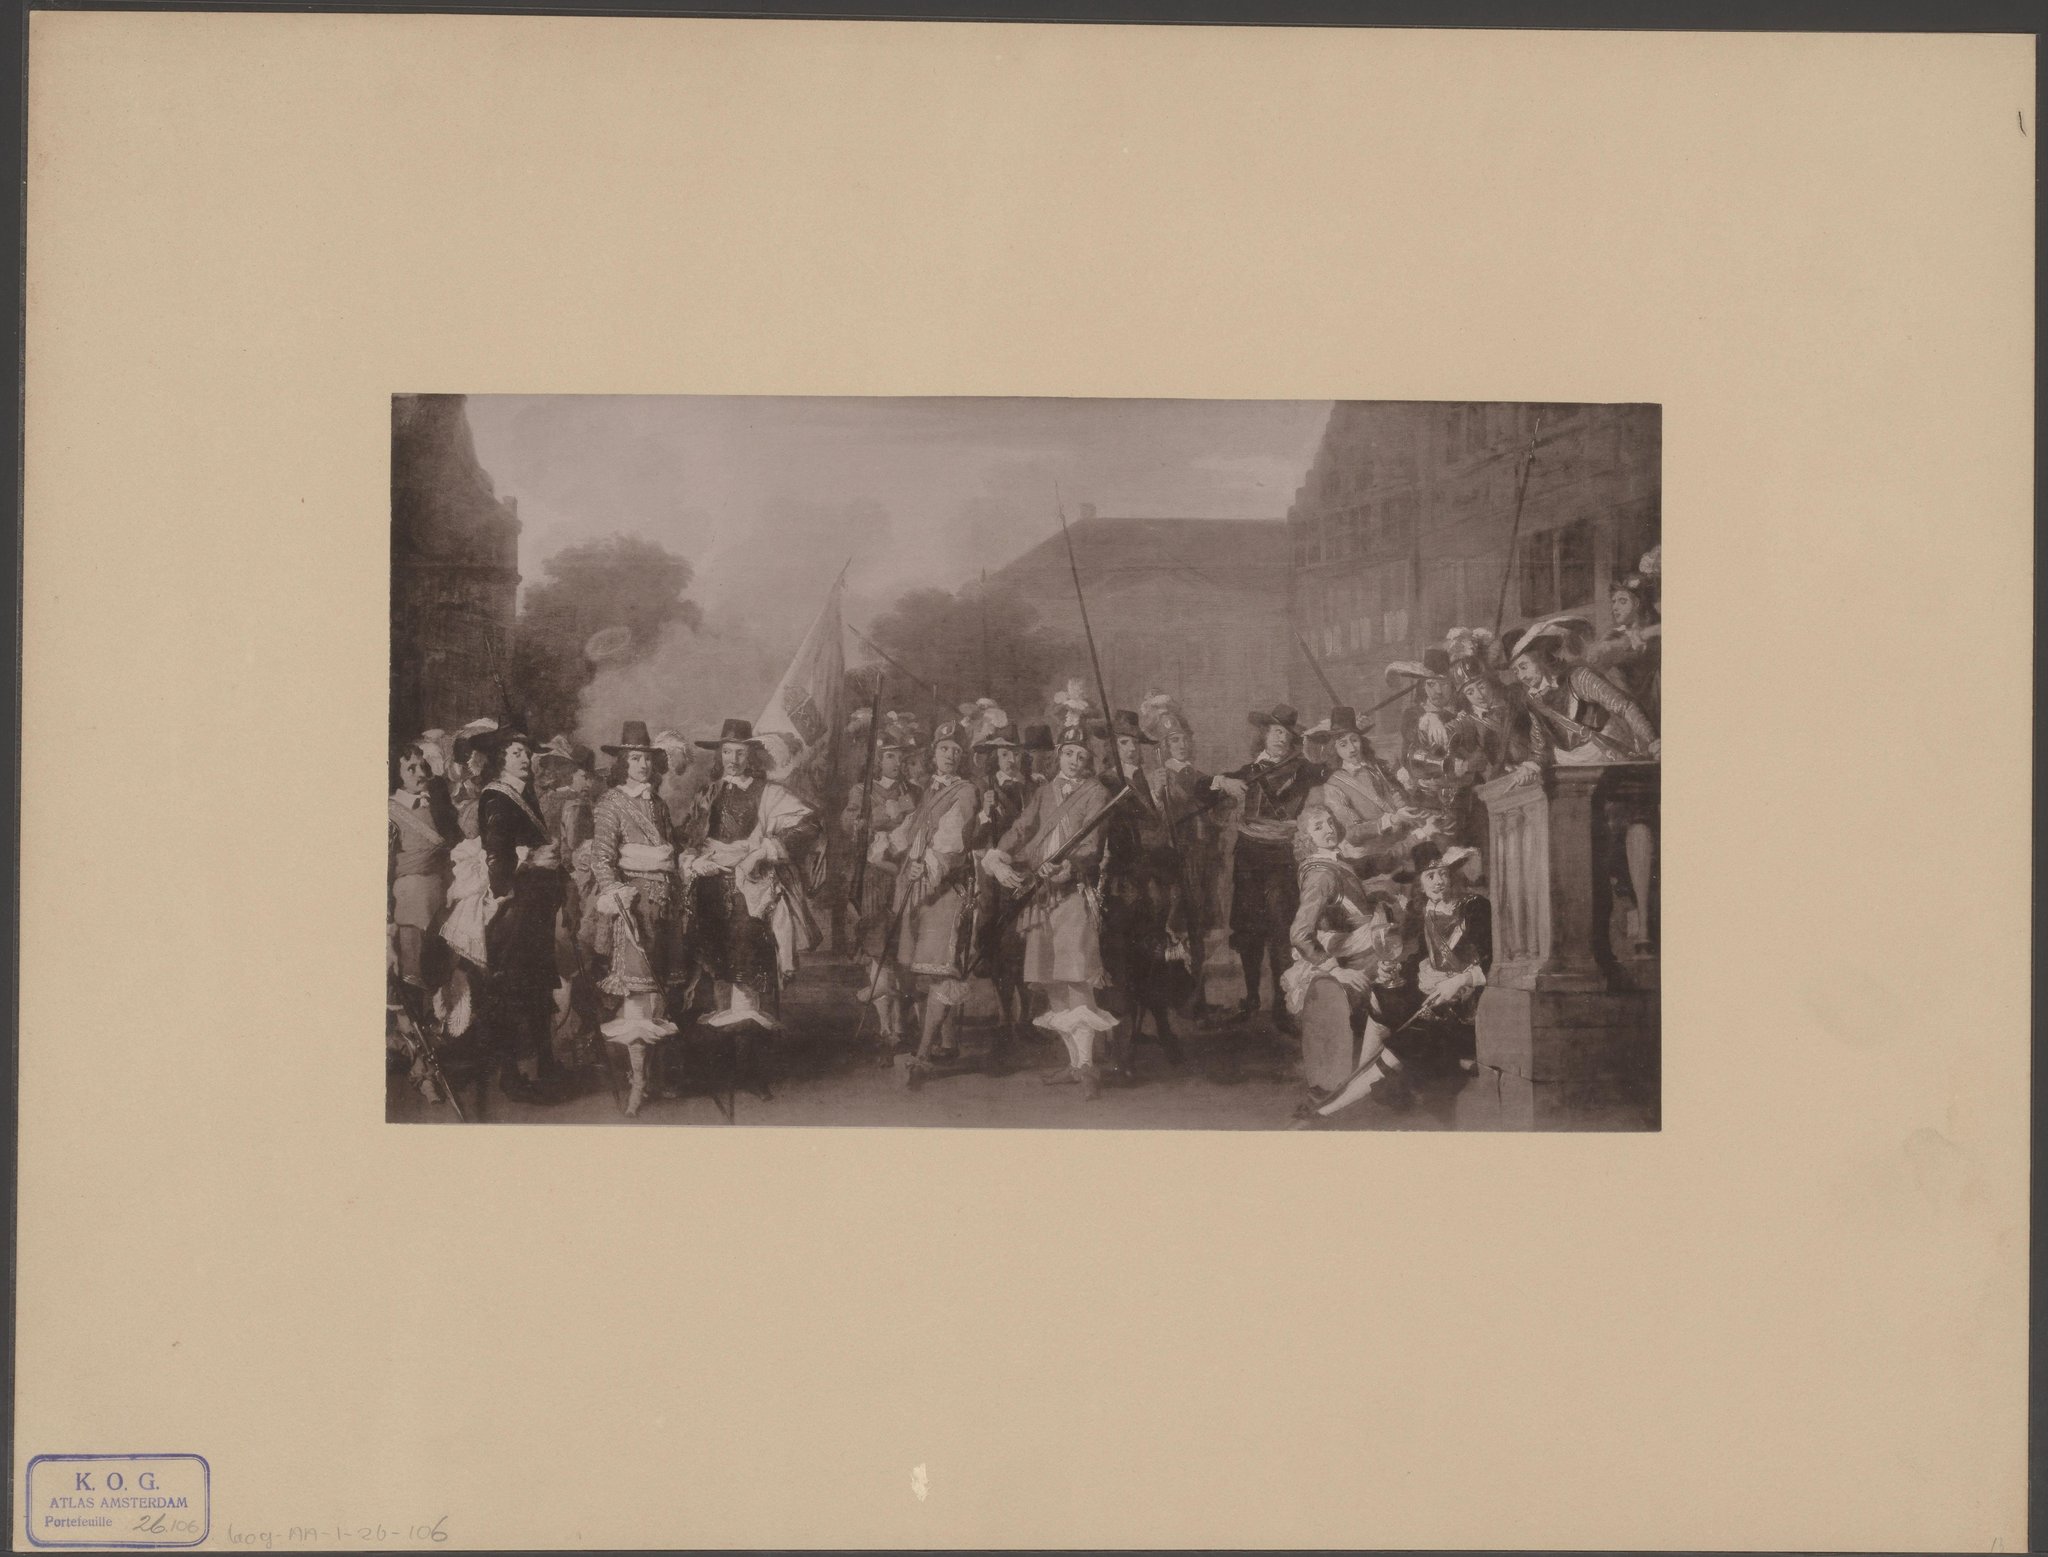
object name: photomechanical print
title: Compagnie van Amsterdamse schutters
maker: Anonymous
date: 1875-1930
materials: paper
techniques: photograph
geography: netherlands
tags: the company, the unit, the troop ~ military service, amsterdam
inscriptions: collector's mark: Lugt 1641b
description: Onderwerpsrubriek binnen de Atlas Amsterdam: Herinneringen aan de Schutterij.